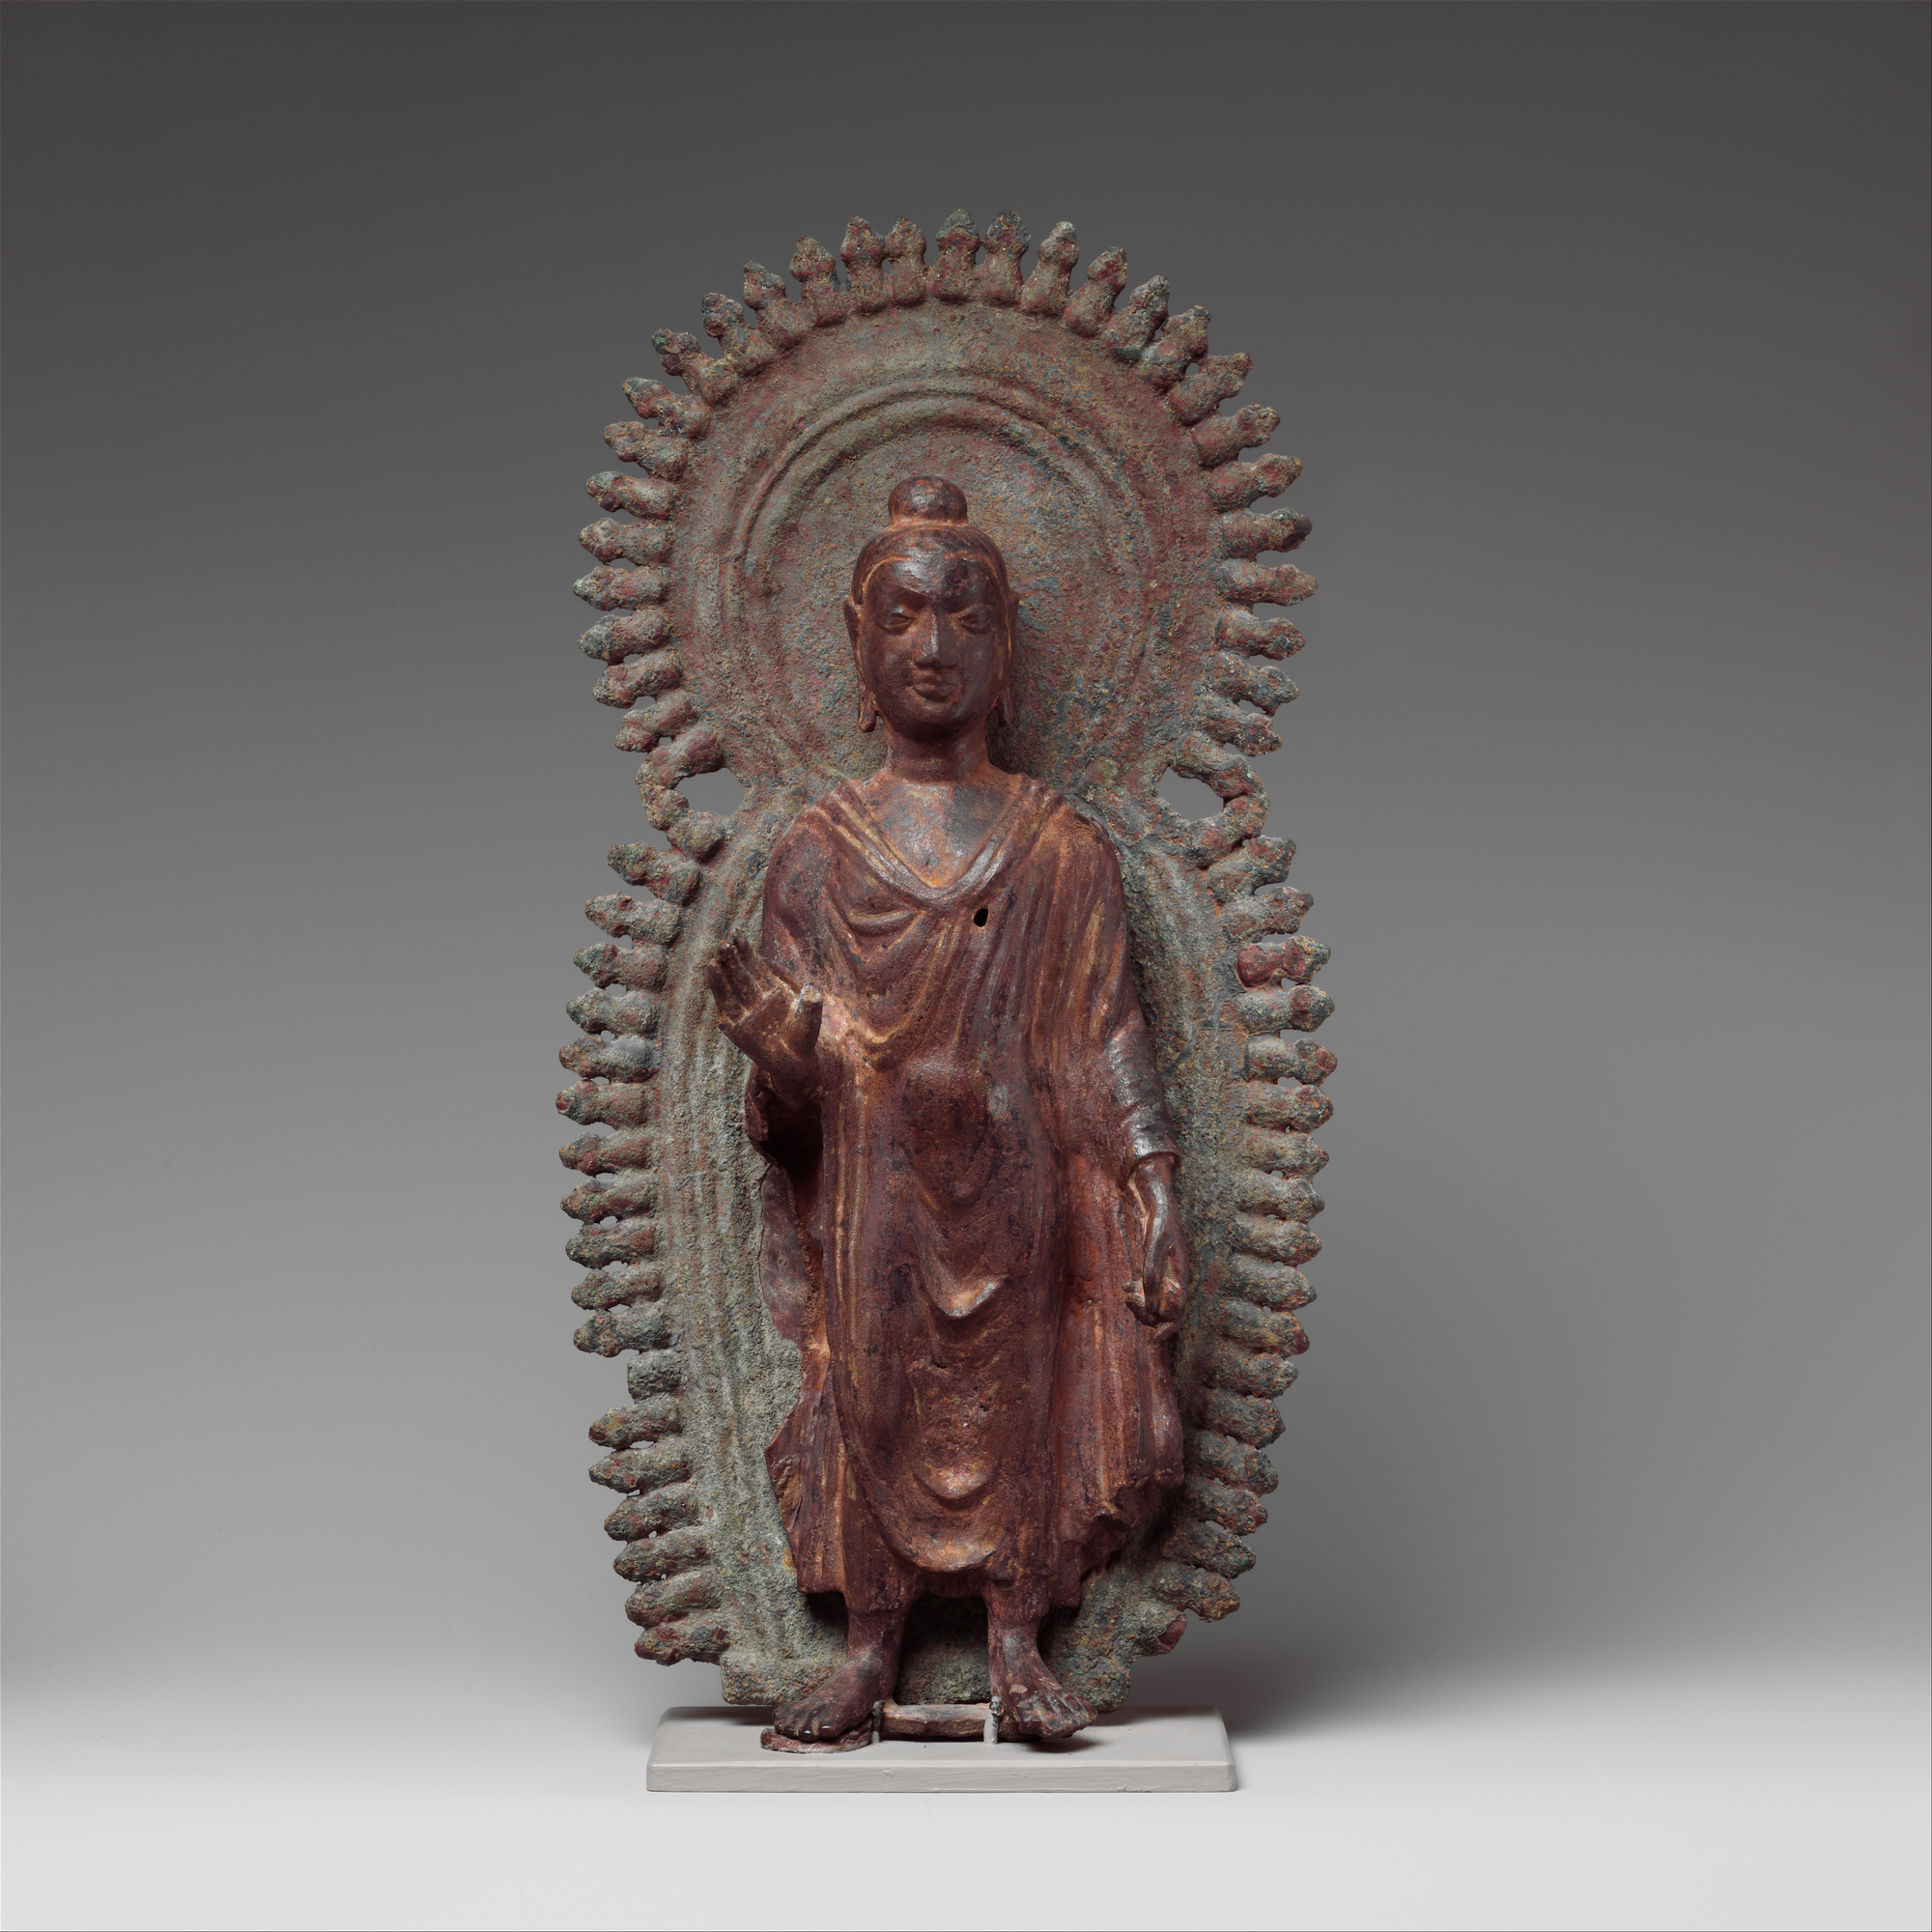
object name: figure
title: Buddha with Radiate Halo and Mandorla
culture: gandhara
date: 501-600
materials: brass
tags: gandhara,buddhism,buddha